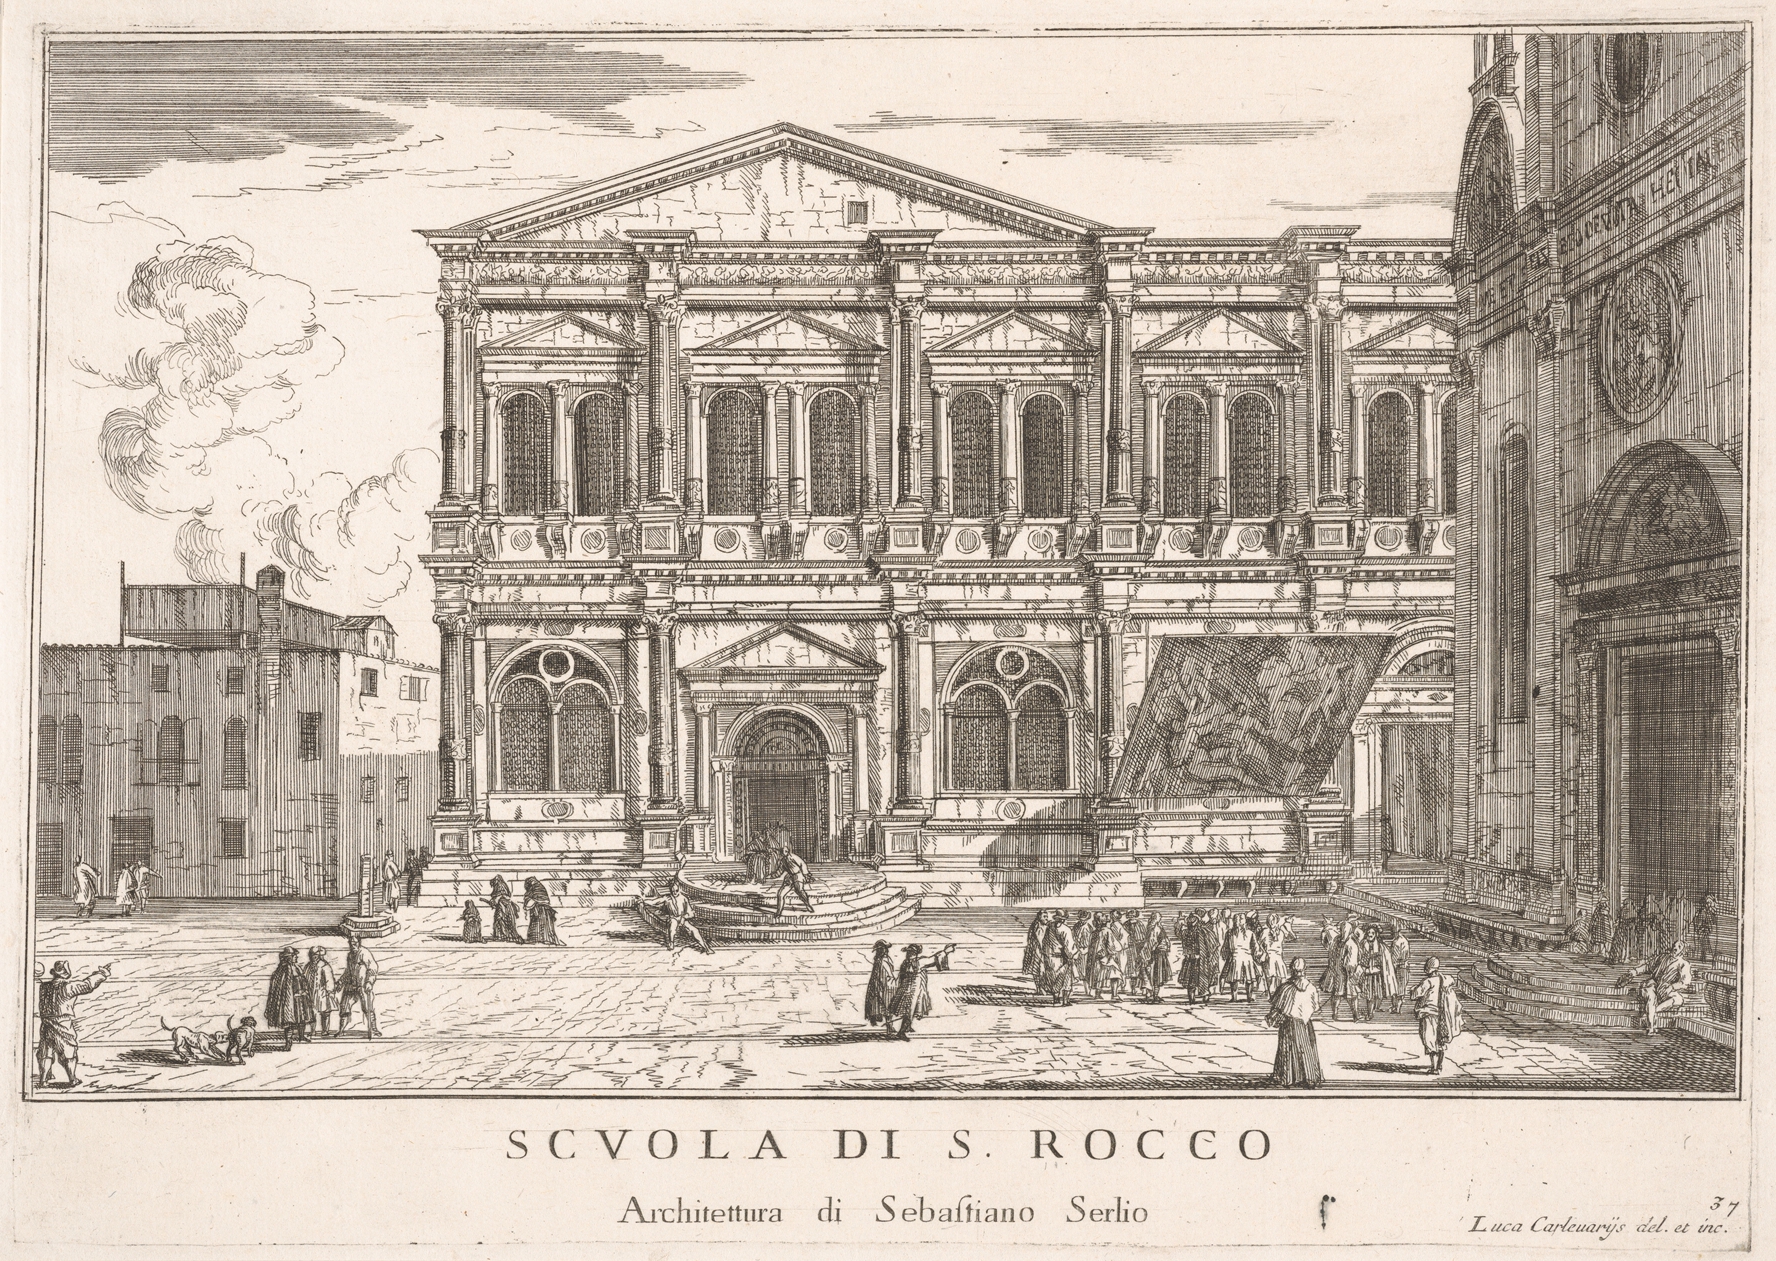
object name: print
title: Plate 37: Side view of the school of St. Roch at left and view of facade of the church of St. Roch, Venice, from "The buildings and views of Venice" (Le fabriche e vedute di Venezia)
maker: luca carlevaris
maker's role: artist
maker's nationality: italian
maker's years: 1663-1730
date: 1703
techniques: etching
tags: schools,churches,venice